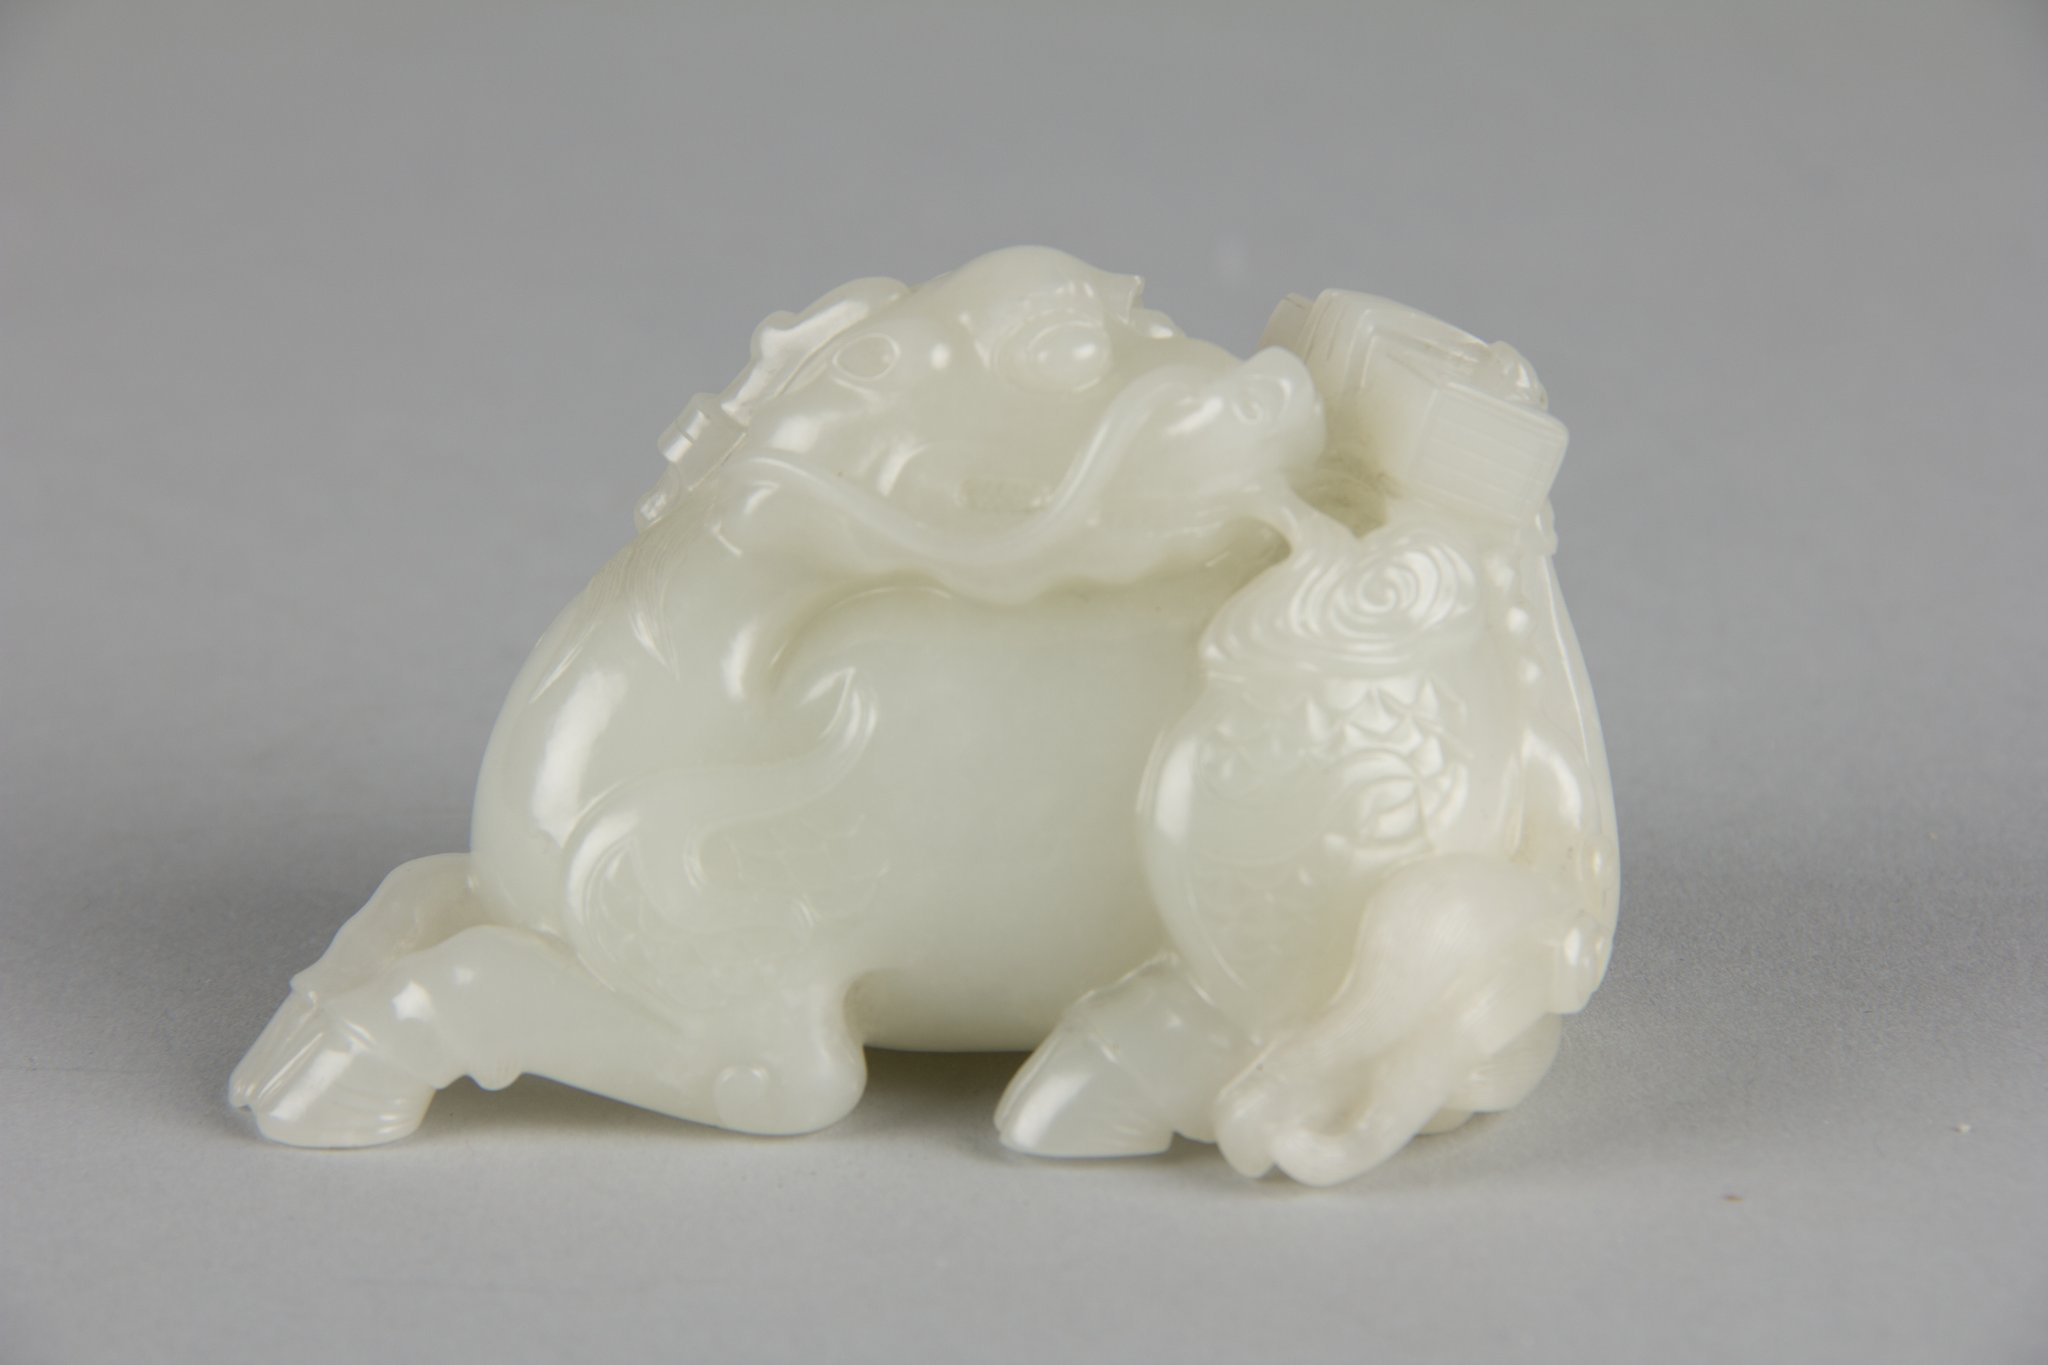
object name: figurine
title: Fantastic animal carrying books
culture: chinese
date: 1767-1833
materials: jade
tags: animals,books